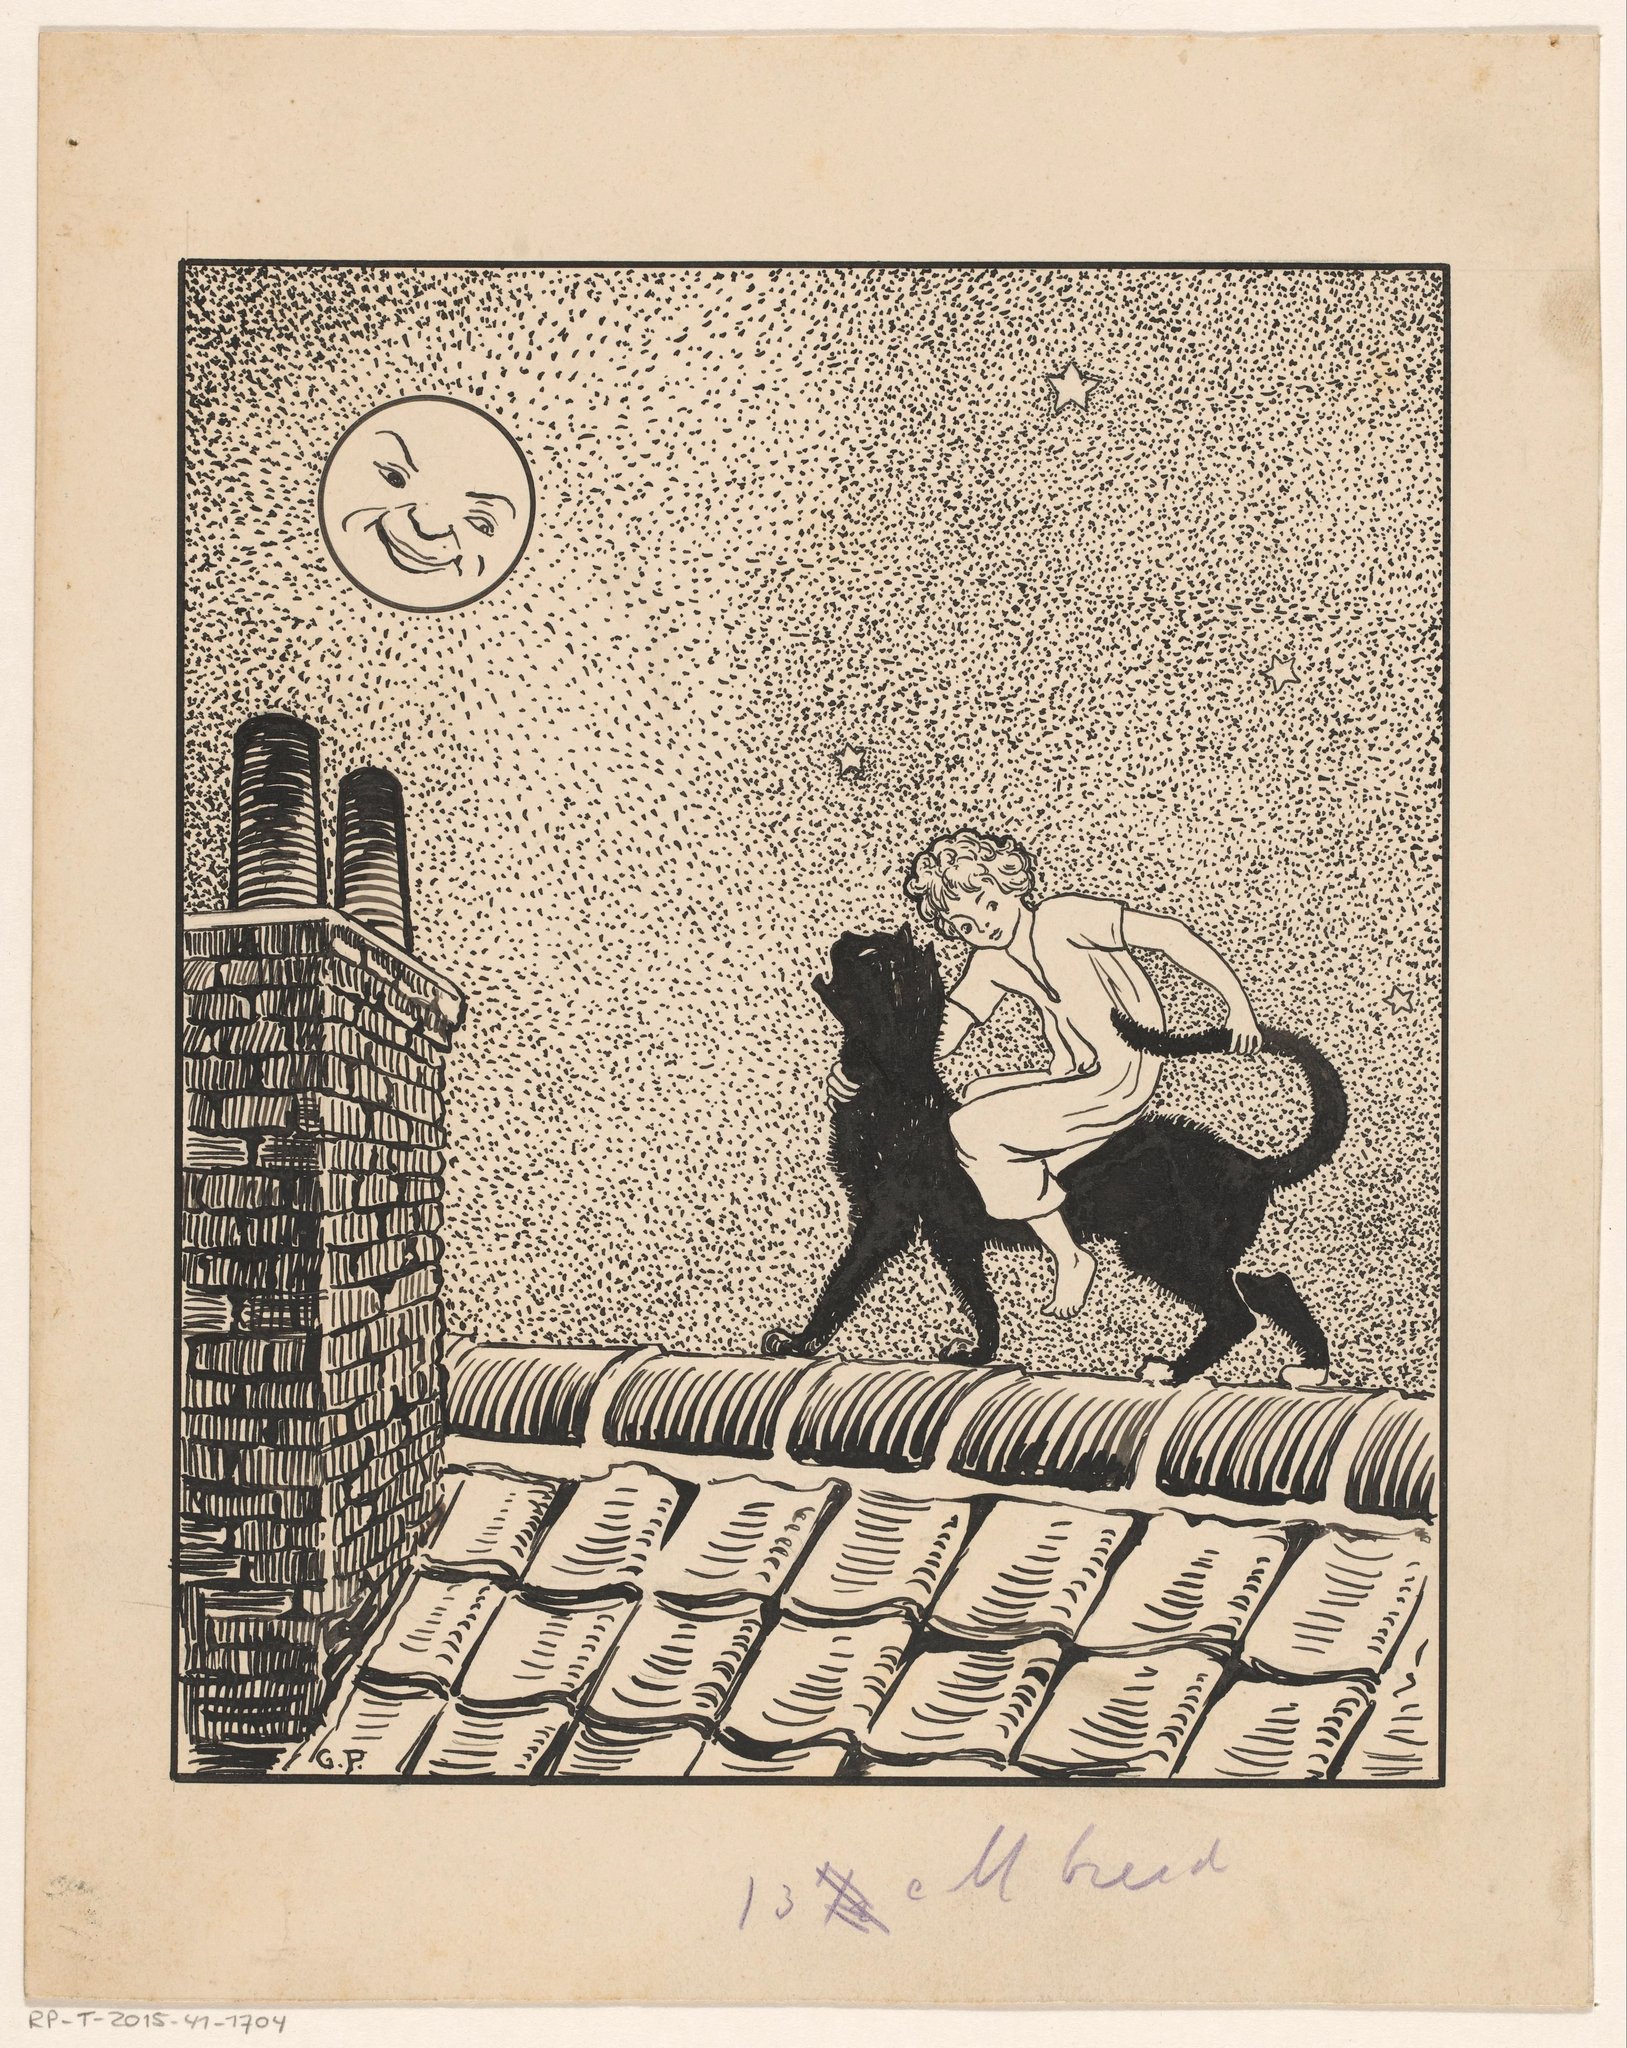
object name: boekillustratie ontwerp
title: Meisje rijdt op een kat over de daken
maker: gust van de wall perné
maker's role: draughtsman, painter, print maker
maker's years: 1877-1911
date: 1887-1911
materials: cardboard, ink, pencil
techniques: pen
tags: roof (of house or building), full moon represented as face, cat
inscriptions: collector's mark: Lugt 2228, :, monogram: ‘G.P’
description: Aan de hemel staat een volle maan in de vorm van een lachend gezicht.